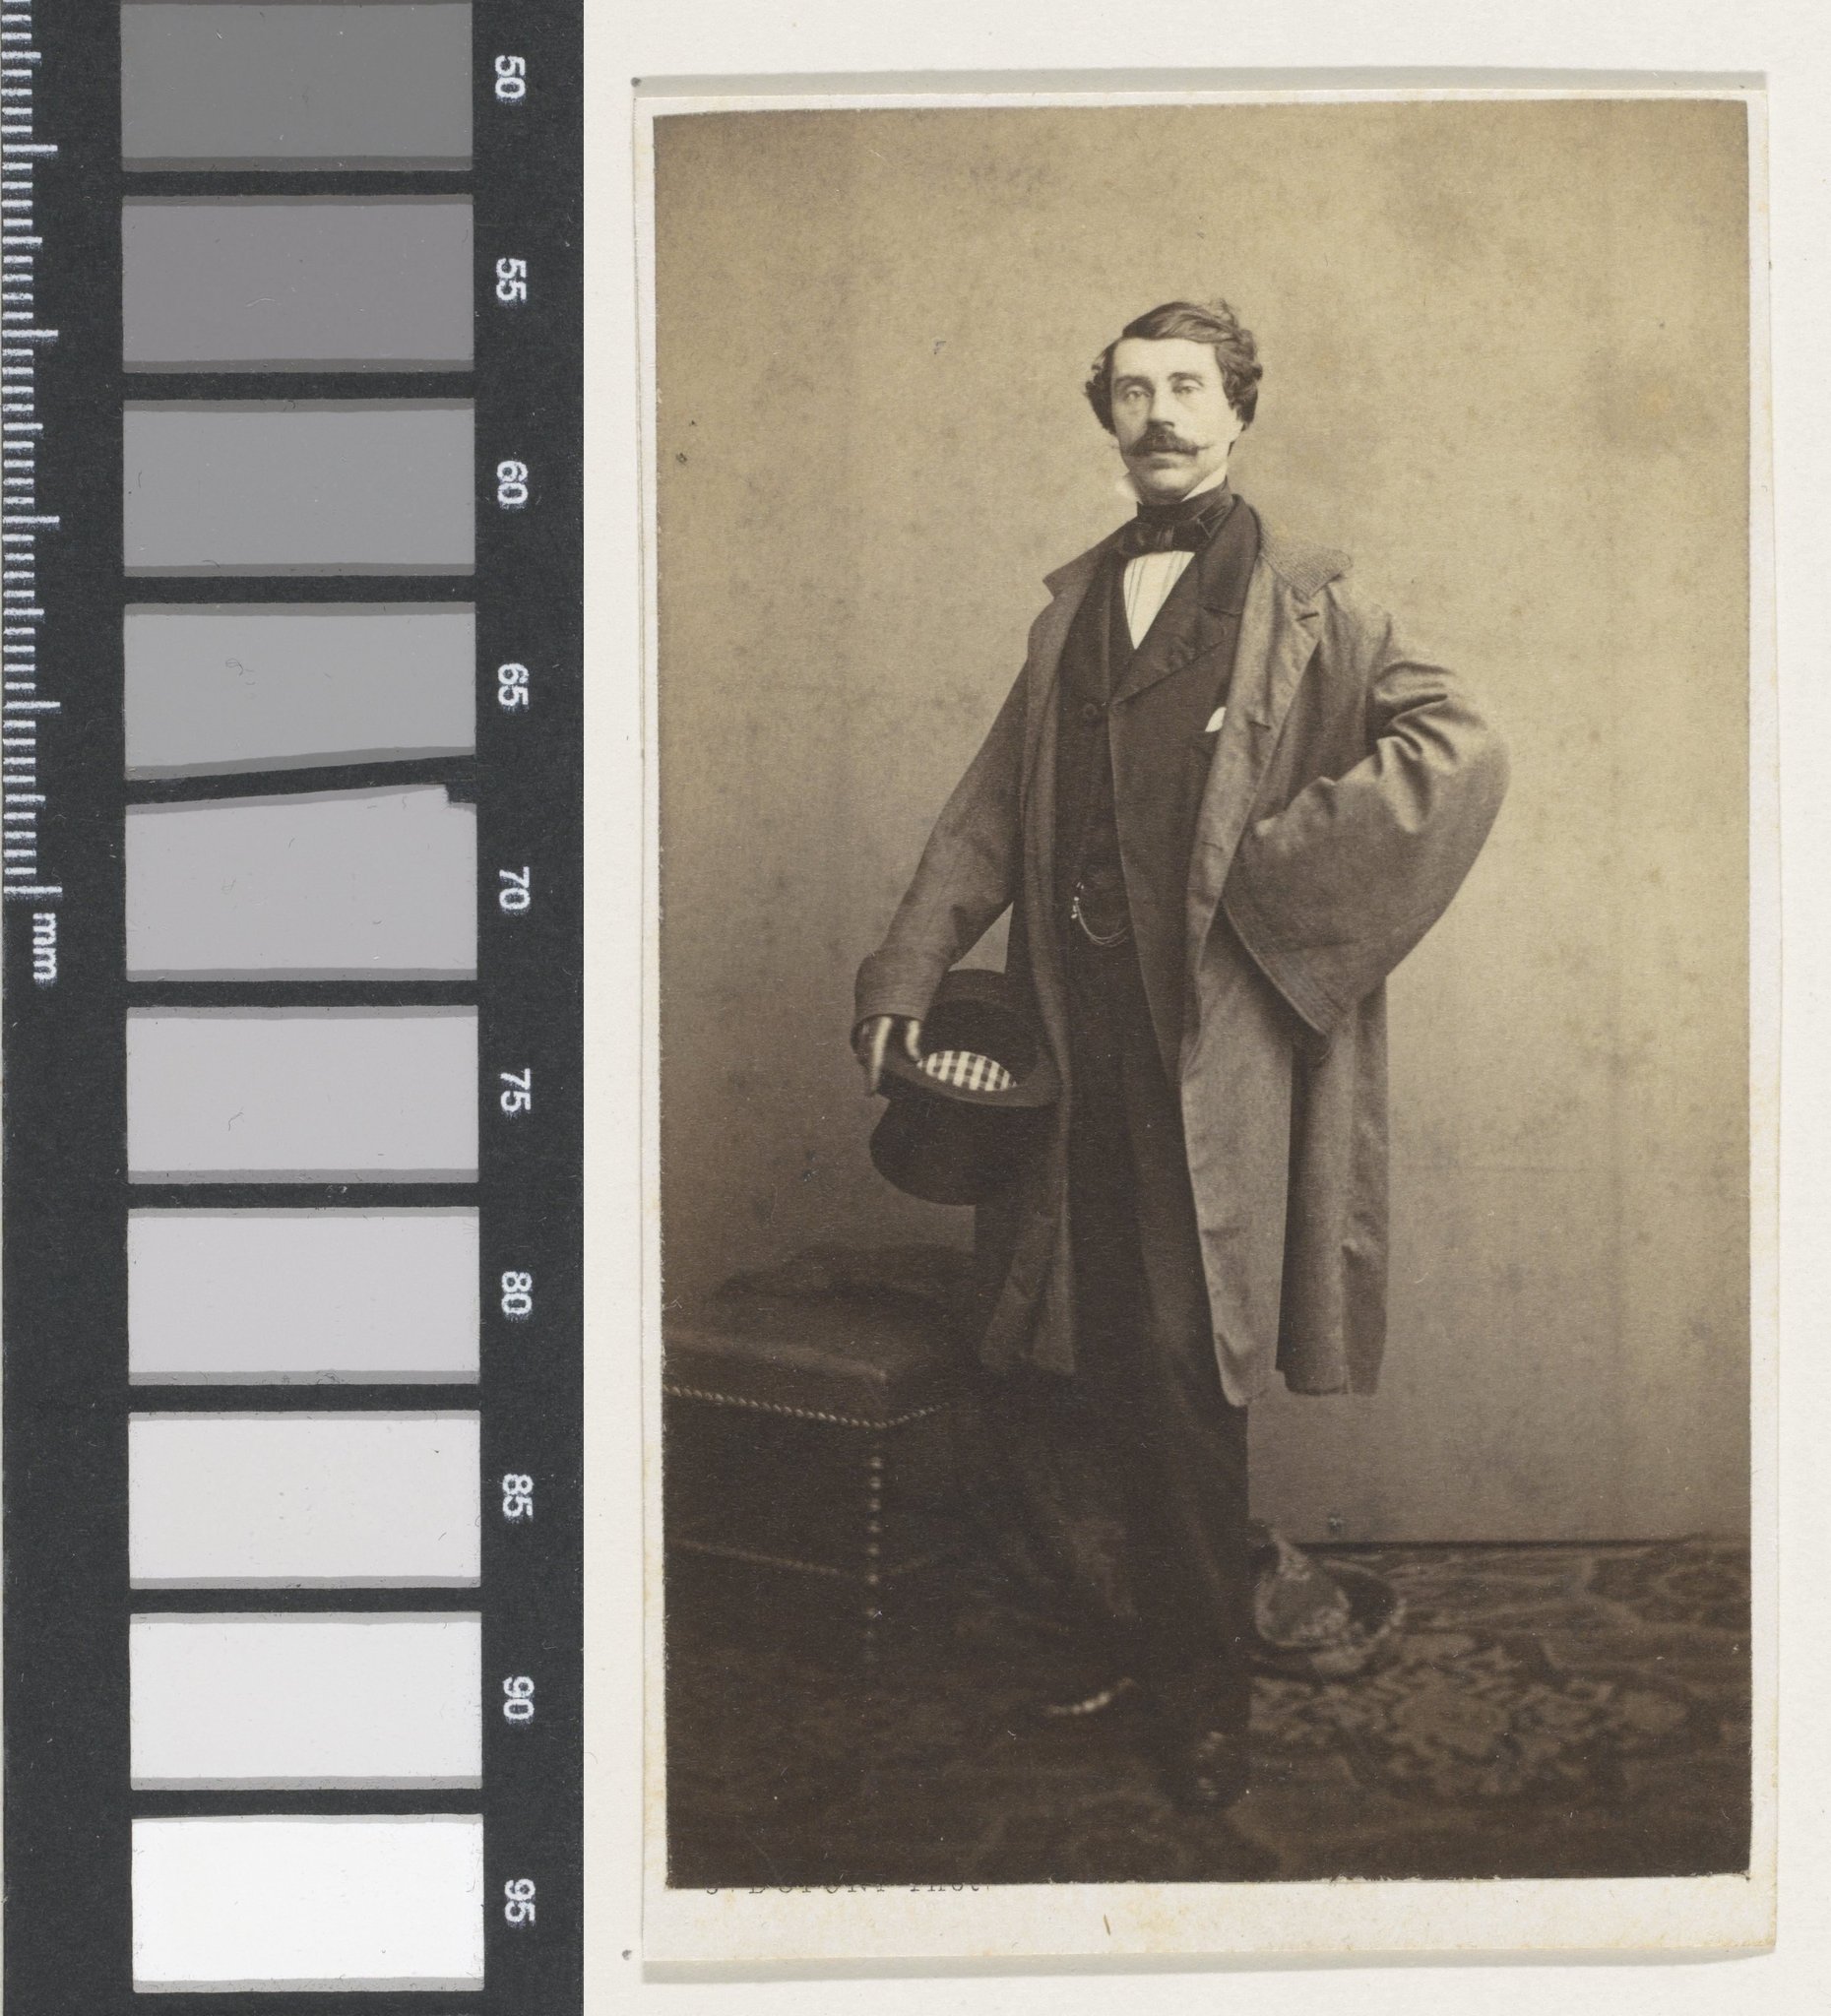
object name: photograph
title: Portret van de schilder Jozef Cornelius Correns, ten voeten uit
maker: joseph dupont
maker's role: fotograaf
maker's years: 1818-1901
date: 1861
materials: cardboard, paper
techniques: albumen print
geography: antwerp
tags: antwerp, painter, draughtsman, jozef cornelius correns, historical persons, portrait, self-portrait of painter, portrait, self-portrait of artist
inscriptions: inscription: ‘ETABLISSEMENT PHOTOGRAPHIQUE/ de/ J. DUPONT/ Place de Meir 32/ ANVERS/ Maison fondée en 1853’